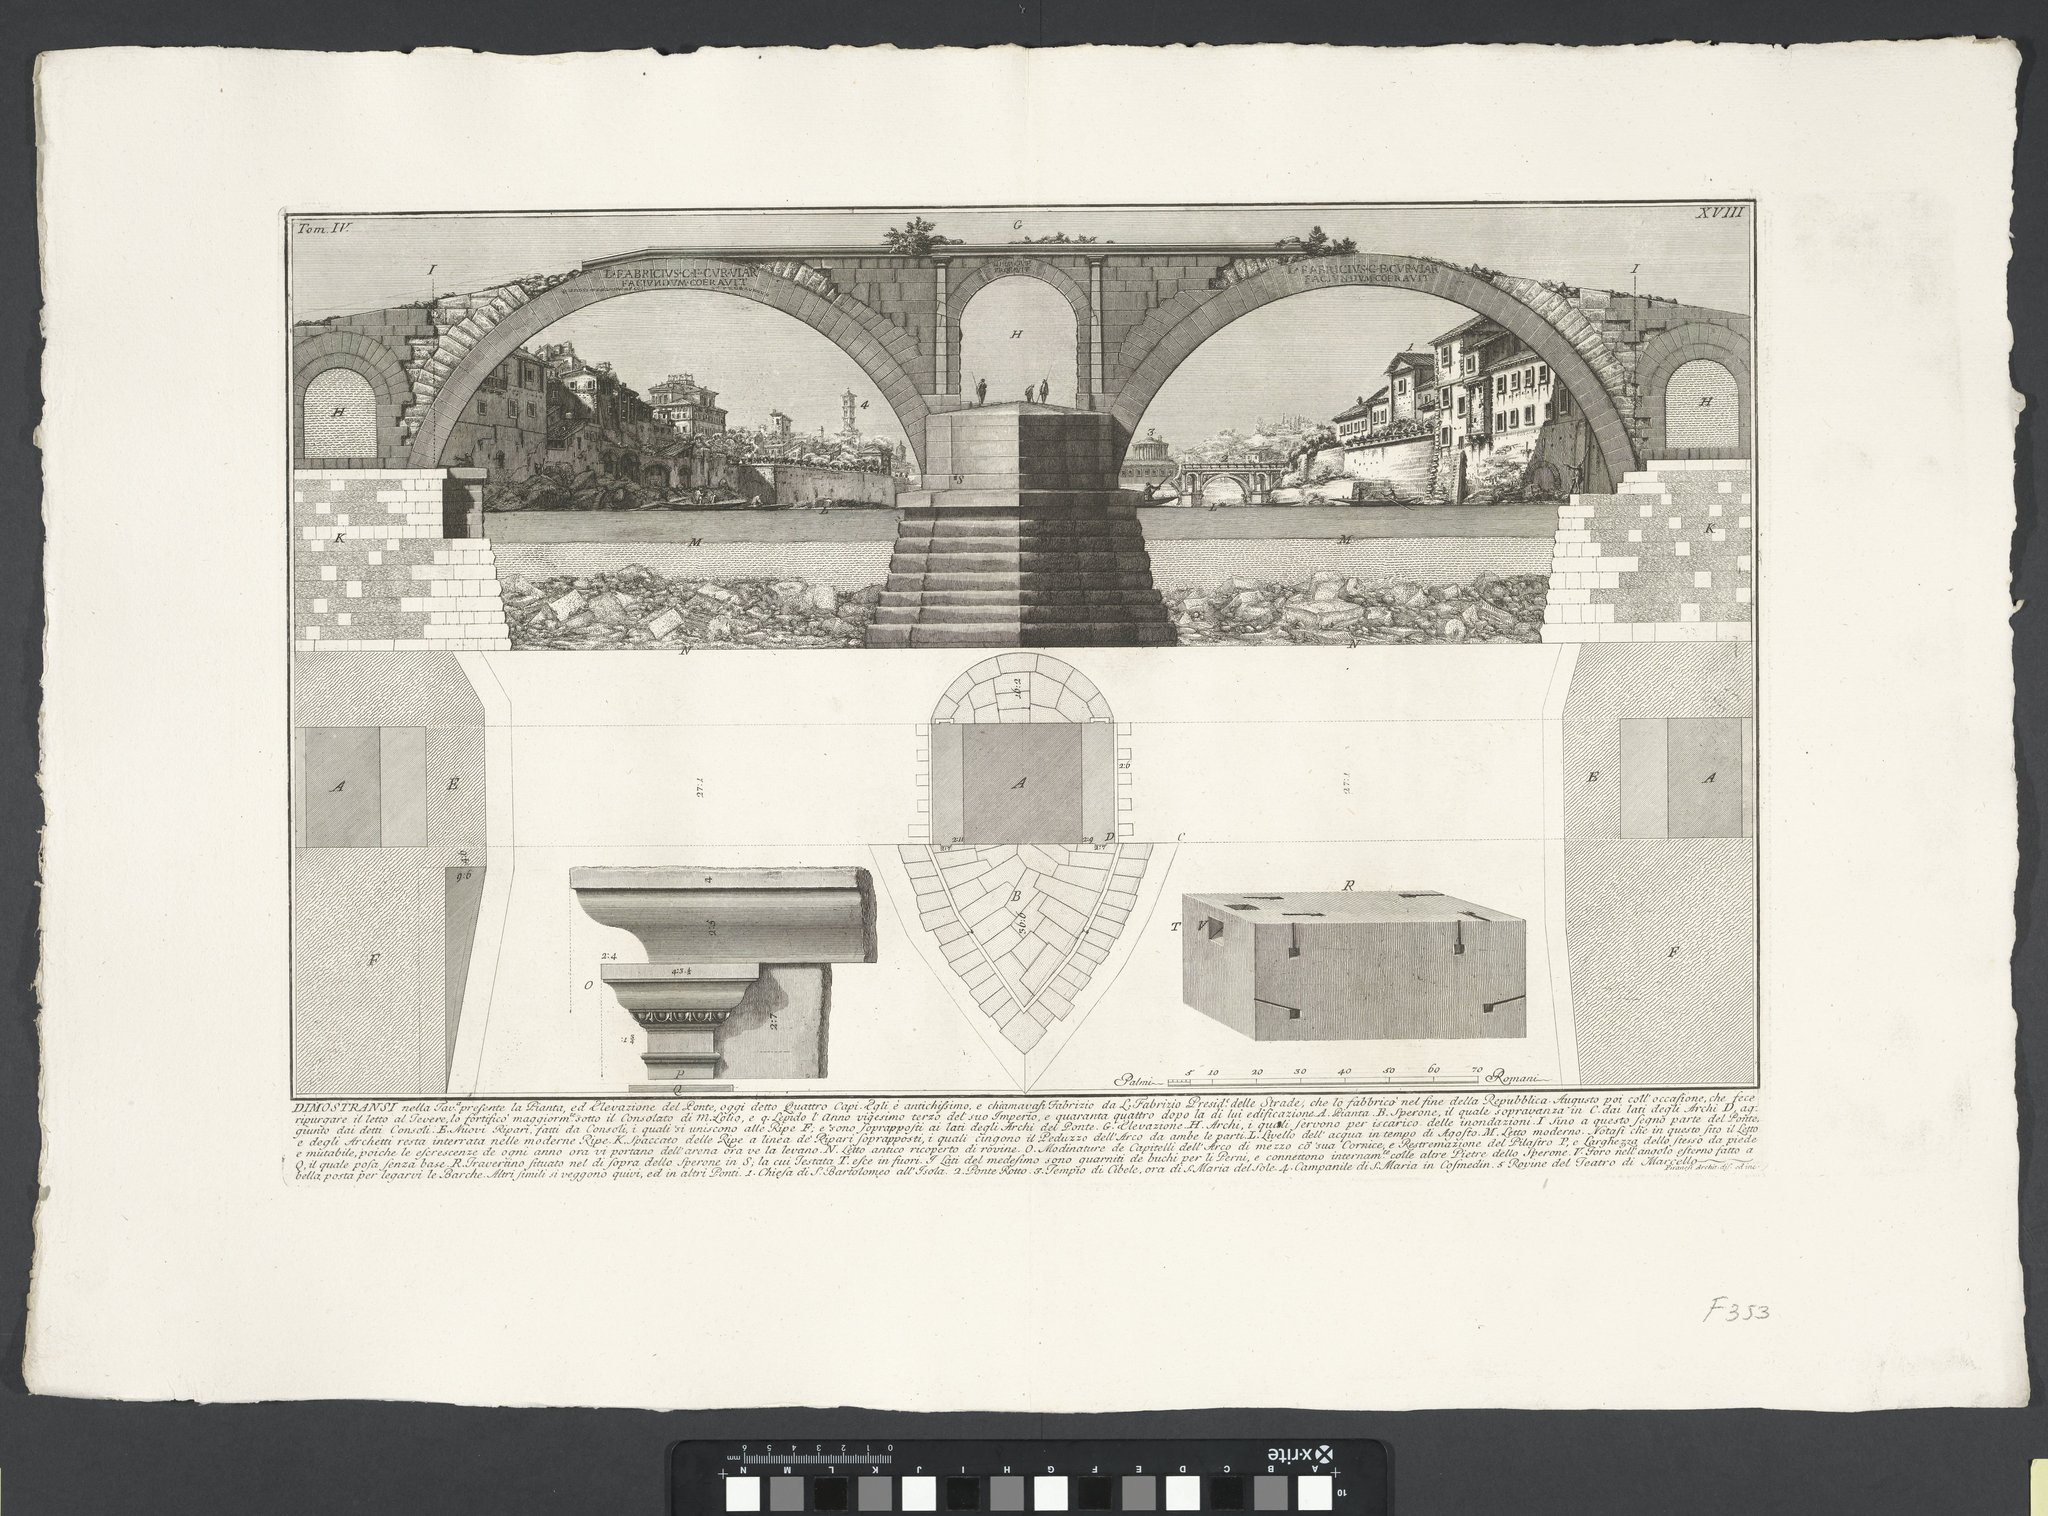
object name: print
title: Archeologische vondsten in en rond Rome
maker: giovanni battista piranesi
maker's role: designer, draughtsman, print maker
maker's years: 1720-1778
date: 1756-1757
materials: paper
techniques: etching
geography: rome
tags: river, bridge, rome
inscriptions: collector's mark: Lugt 2228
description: Deze prent maakt deel uit van de serie 'Le Antichità Romane'. Piranesi deed meer dan acht jaar voorstudie voor deze 250 platen tellende serie die in vier volumes werd uitgegeven. Hij produceerde de prenten tussen ca. 1756 en 1757. De serie bevat ook prenten door of naar andere prentmakers, onder wie Francesco Bianchini en Girolamo Rossi.